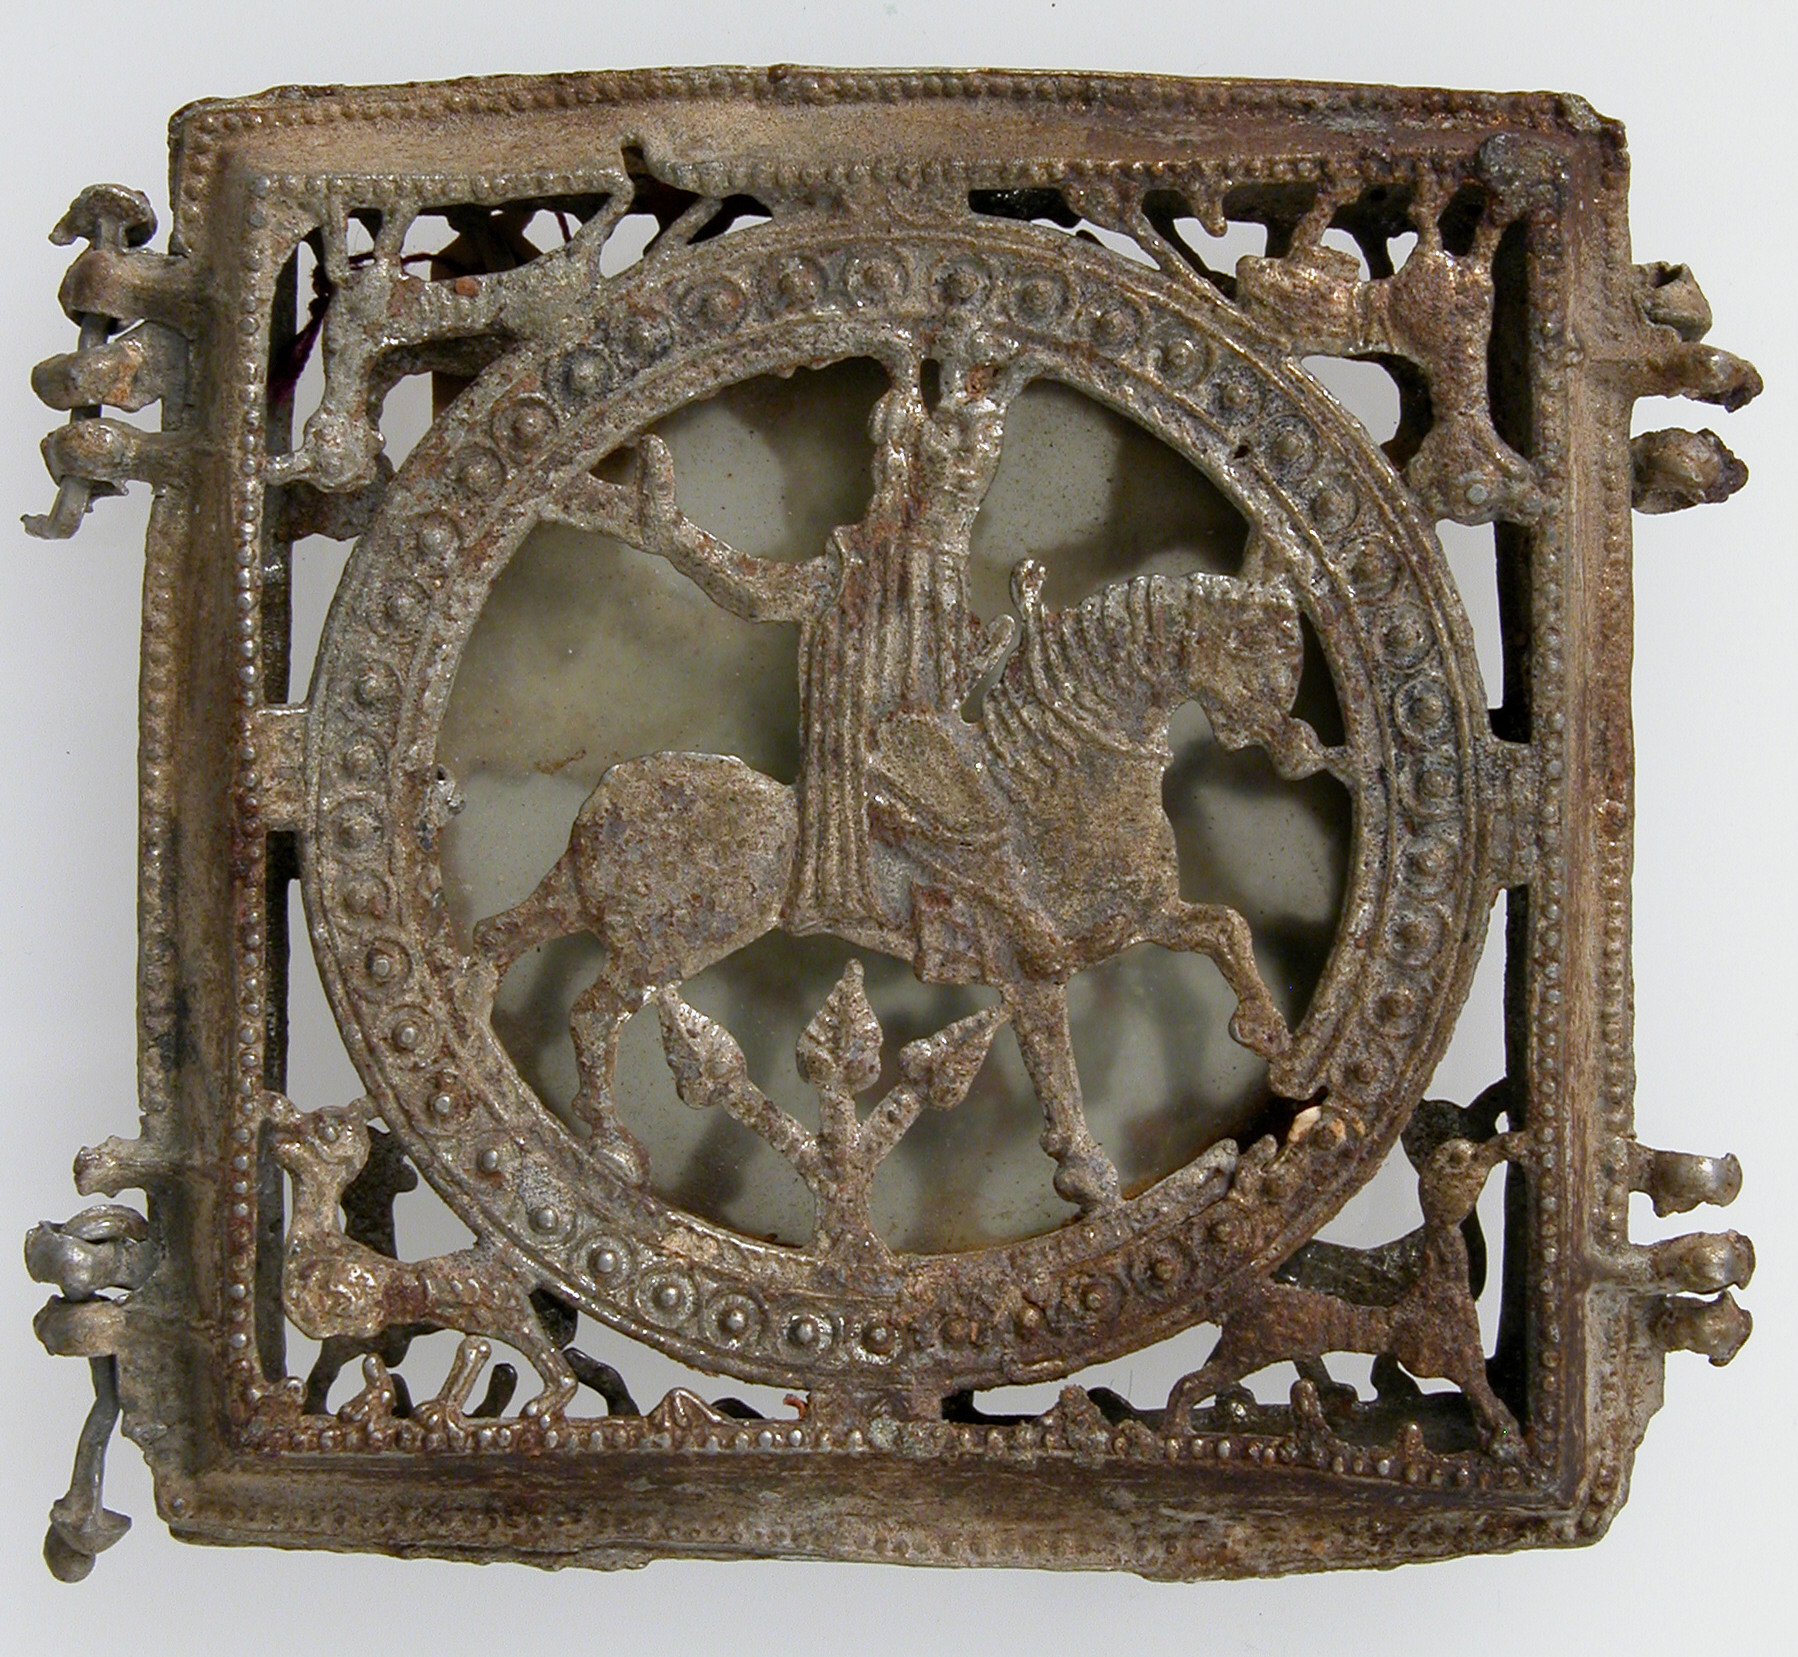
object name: pilgrim's badge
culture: european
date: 1301-1400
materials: lead, wax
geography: italy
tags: men,horses